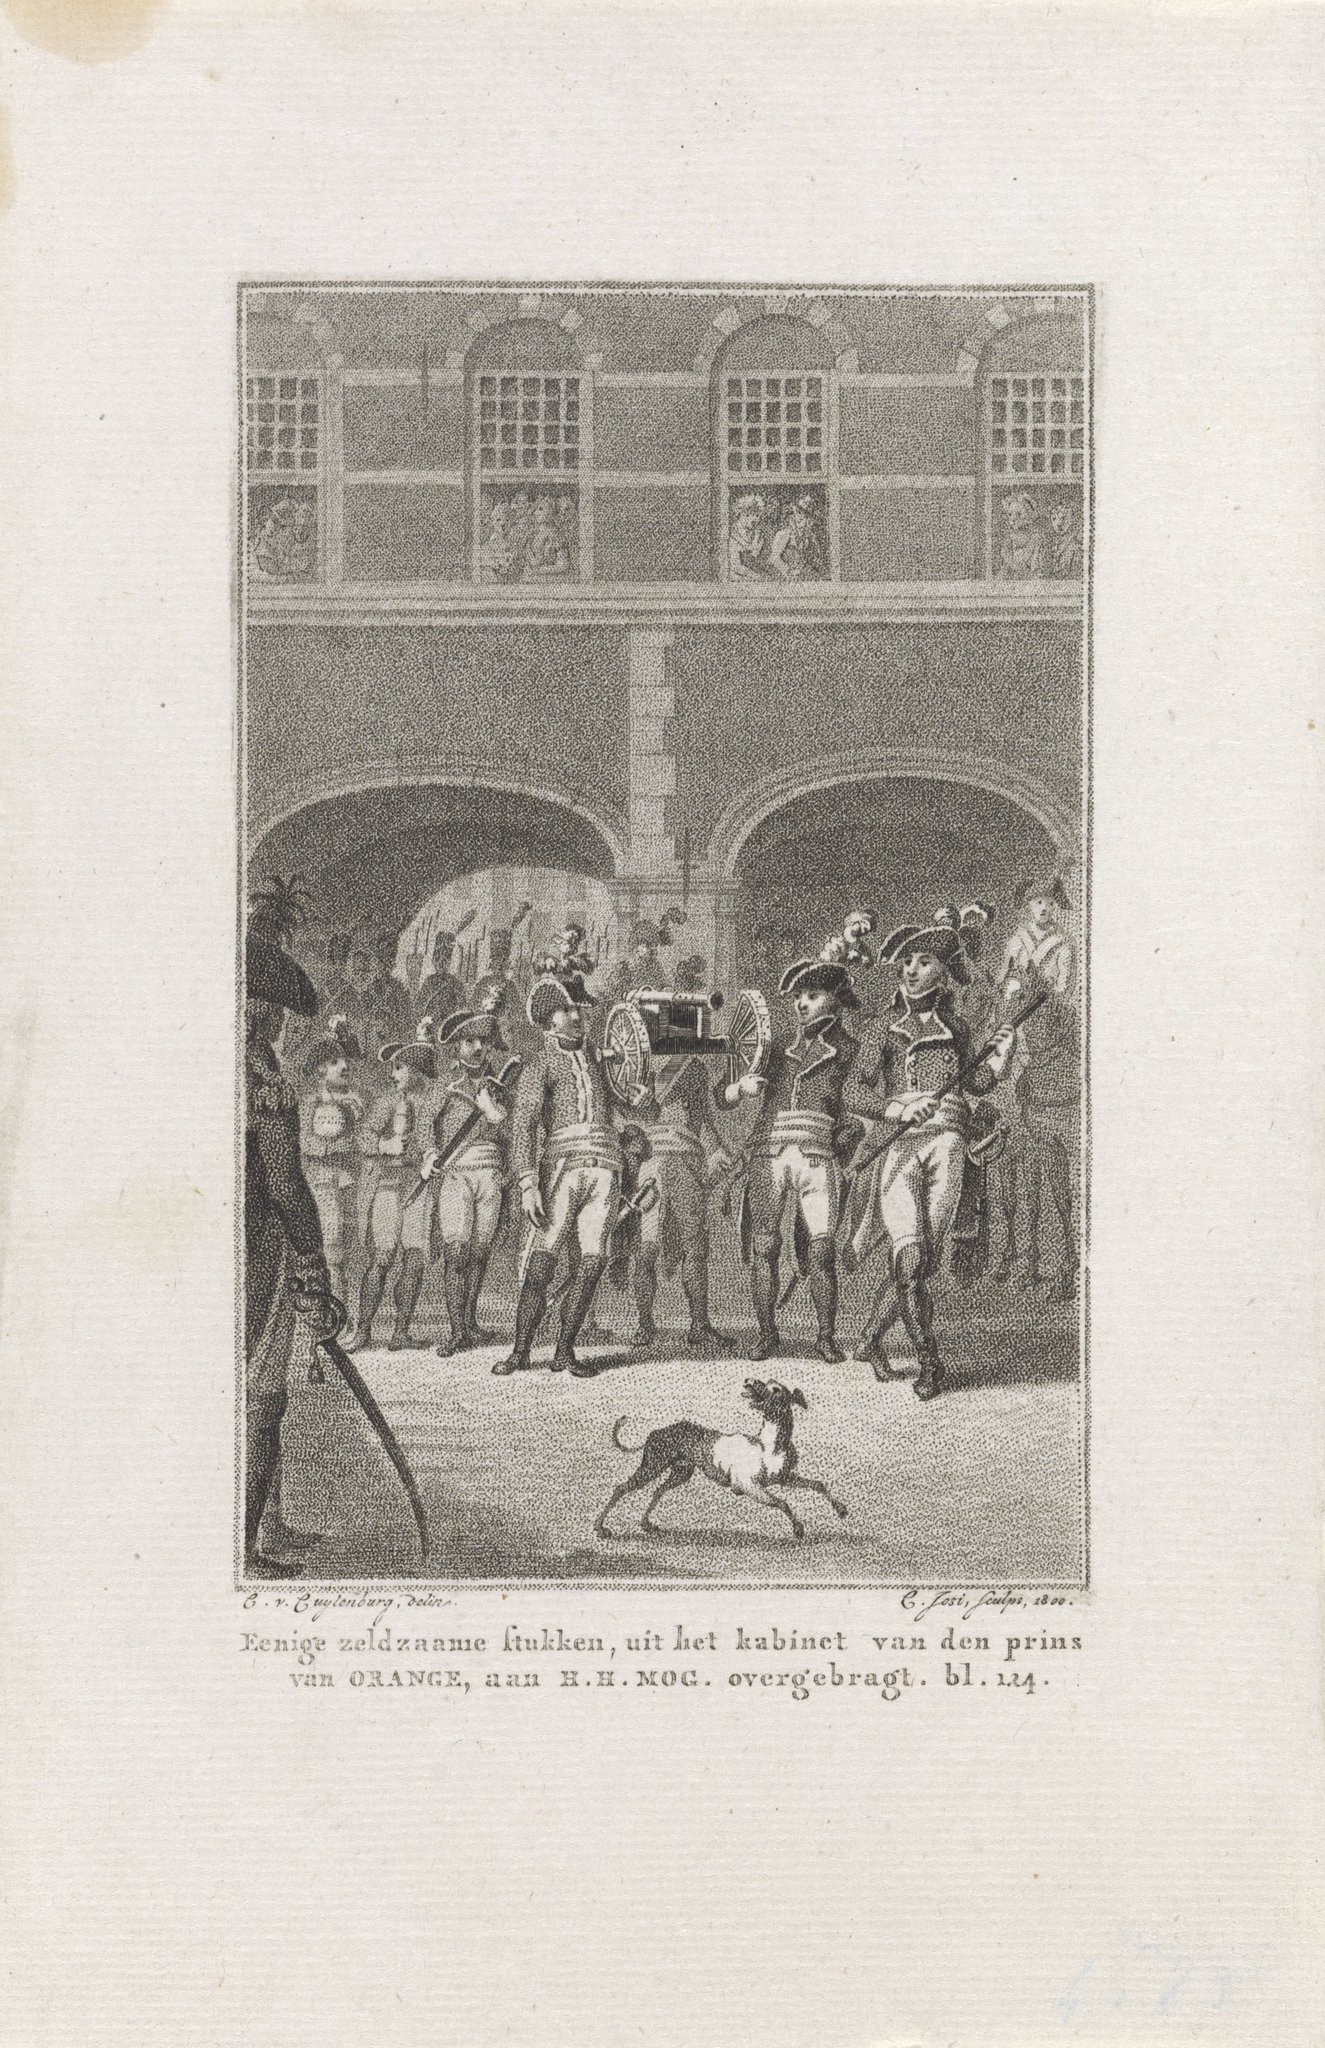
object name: print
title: Teruggave door de Fransen van historische stukken uit stadhouderlijke collectie aan de Staten-Generaal, 1795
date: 1798-1800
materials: paper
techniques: stippled etching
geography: northern netherlands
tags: william v (prince of orange), rijksmuseum amsterdam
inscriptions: collector's mark: Lugt 2228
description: Ceremonie met de teruggave door de Fransen onder leiding van generaal J.B. Dumonceau van vijf belangrijke historische stukken uit de geconfisqueerde stadhouderlijke collectie van Willem V. Franse militairen dragen de stukken over het plein van het Binnenhof ter overdracht aan de Staten-Generaal, 12 maart 1795.